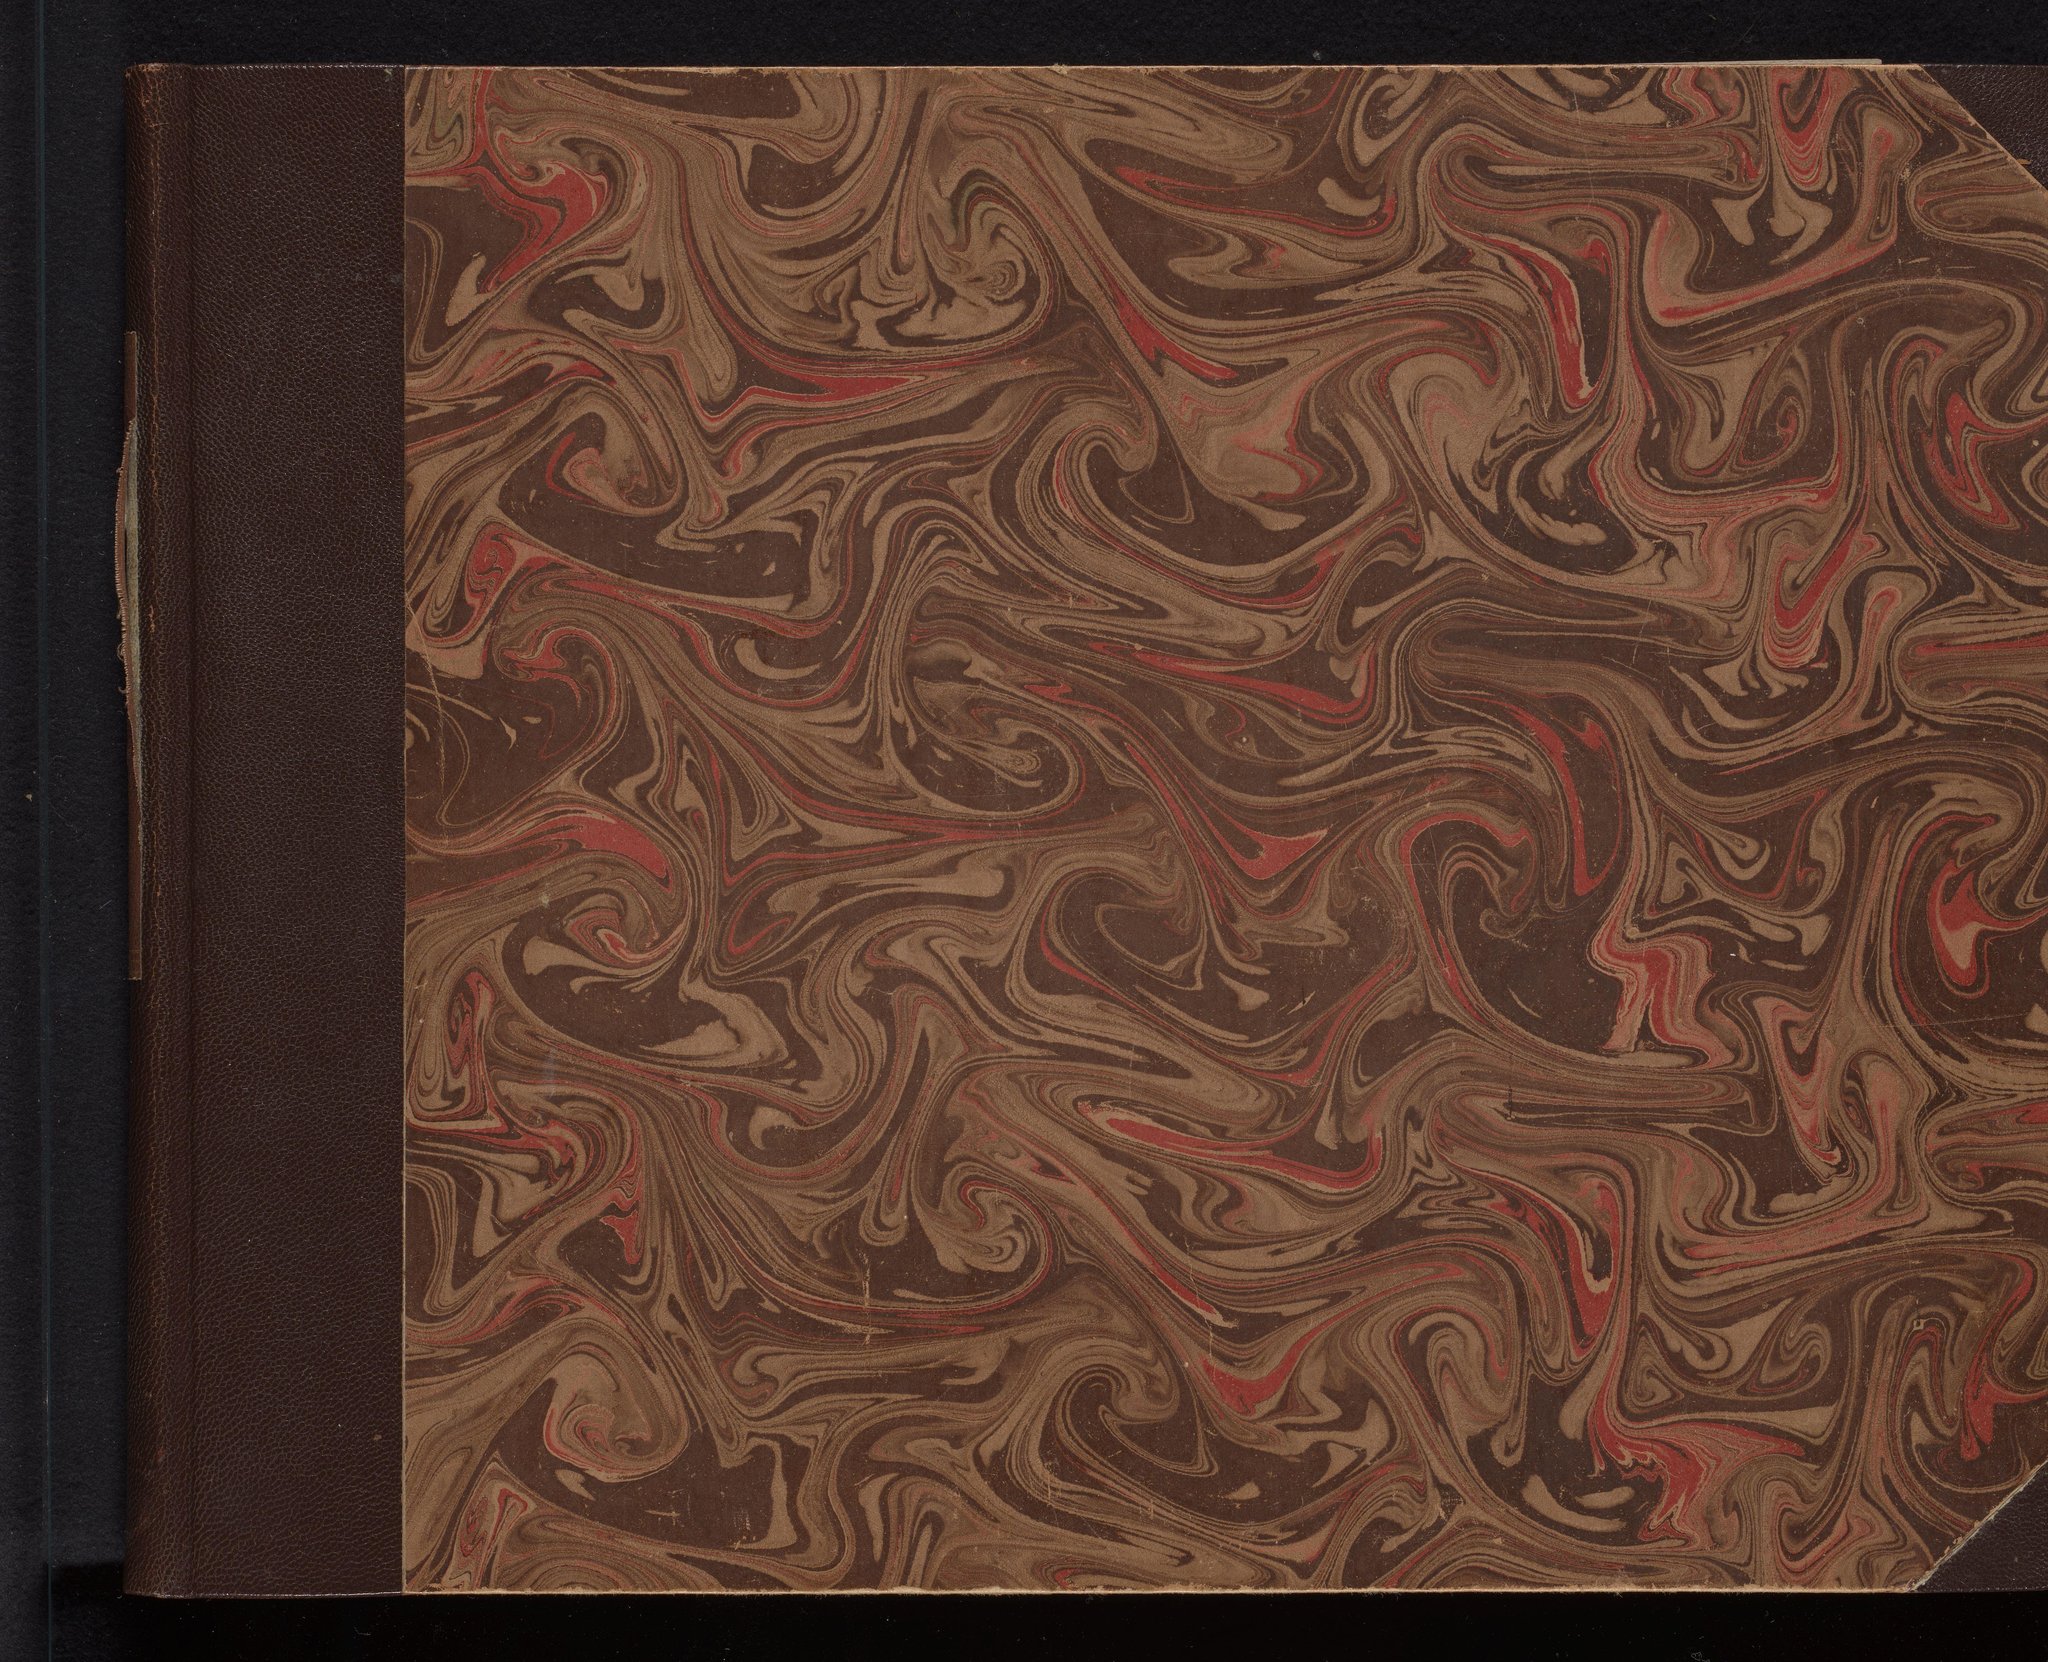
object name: prentrecueil, prentenalbum, prentalbum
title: Vredeman de Vries - Architectura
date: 1565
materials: leather, paper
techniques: bookbinding, decorated paper, etching, letterpress printing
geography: antwerp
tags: orders, order-books ~ architecture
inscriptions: collector's mark: ‘Legaat Godefroy No 799’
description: Album met 53 voorstellingen 56 albumbladen. Het album bevat drie series gegraveerd door Johannes of Lucas van Doetechum naar ontwerp van Vredeman de Vries. Het gaat om: Den eersten boeck ghemaeckt op de twee Colomnen Dorica en Ionica, 1565; Das ander Buech, gemacht auff die zway Colonnen Corinthia und Composita, 1565 en Architectura de Oorden Tuschana, 1578. Het betreft afbeeldingen van piëdestals, postamenten, hoofdgestellen, consoles, kapitelen, gevels en vensters in de Dorische, Ionische, Korinthische, Composiete en Toscaanse Orde. Elke serie gaat vooraf door een titelpagina en inleiding. Halfleren band met platten van sierpapier, voorin en achterin een schutblad.